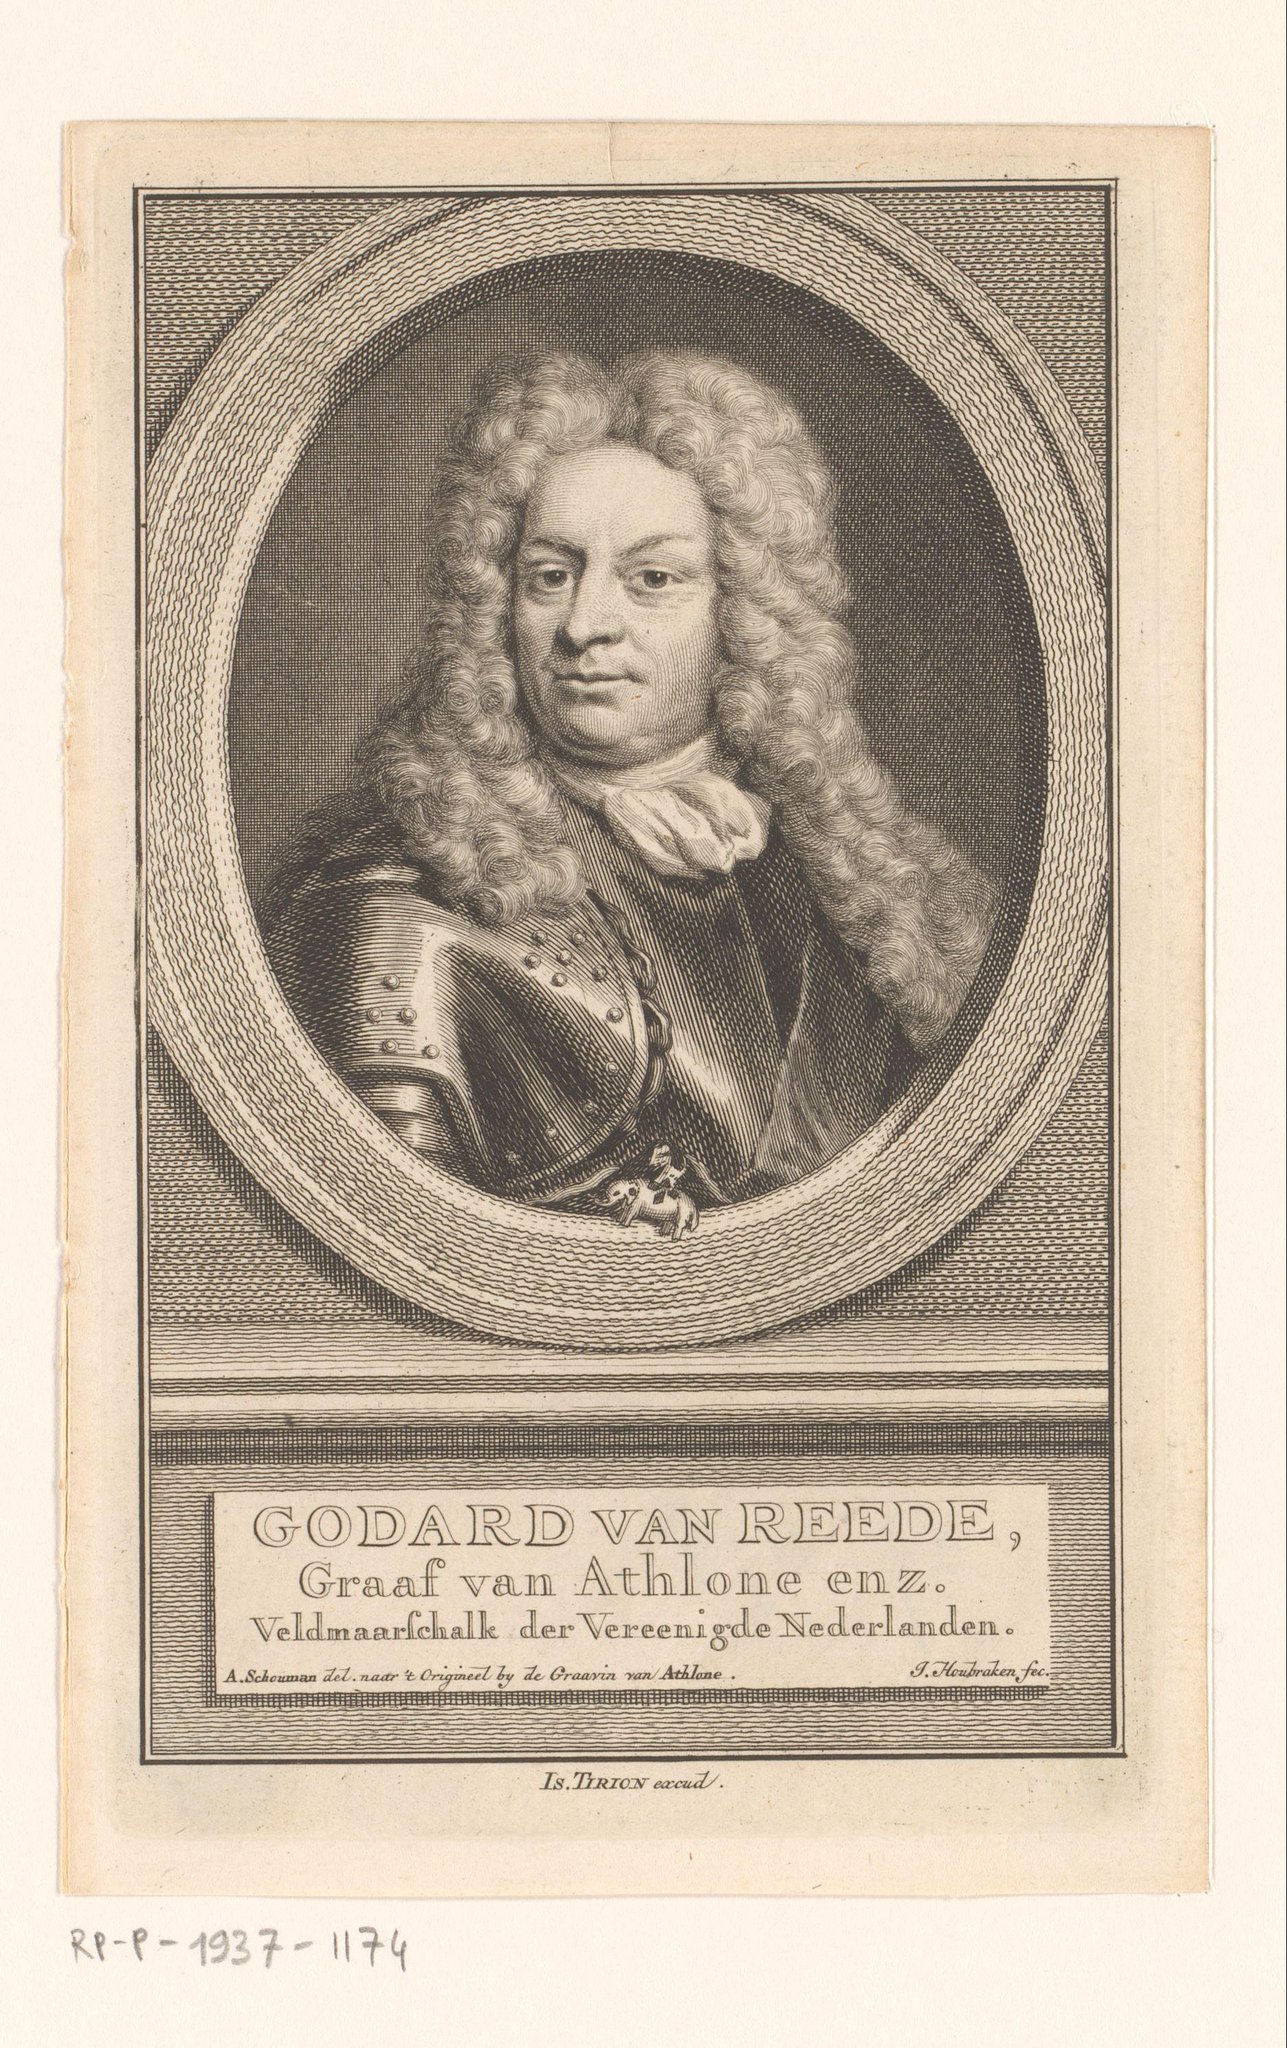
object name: print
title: Portret van Godard van Reede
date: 1757-1795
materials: paper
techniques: engraving, etching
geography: amsterdam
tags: godard van reede, ornament ~ medallion, commander-in-chief, general, marshal, historical persons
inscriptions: collector's mark: Lugt 2228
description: Prent waarschijnlijk uit: Wagenaar, Jan. Vaderlandsche historie, vervattende de geschiedenissen der nu Vereenigde Nederlanden (...). Amsterdam: Isaak Tirion, 1757, dl. 17. Of uit een latere editie uit 1770, 1782 of 1795, zie ook Van Someren.